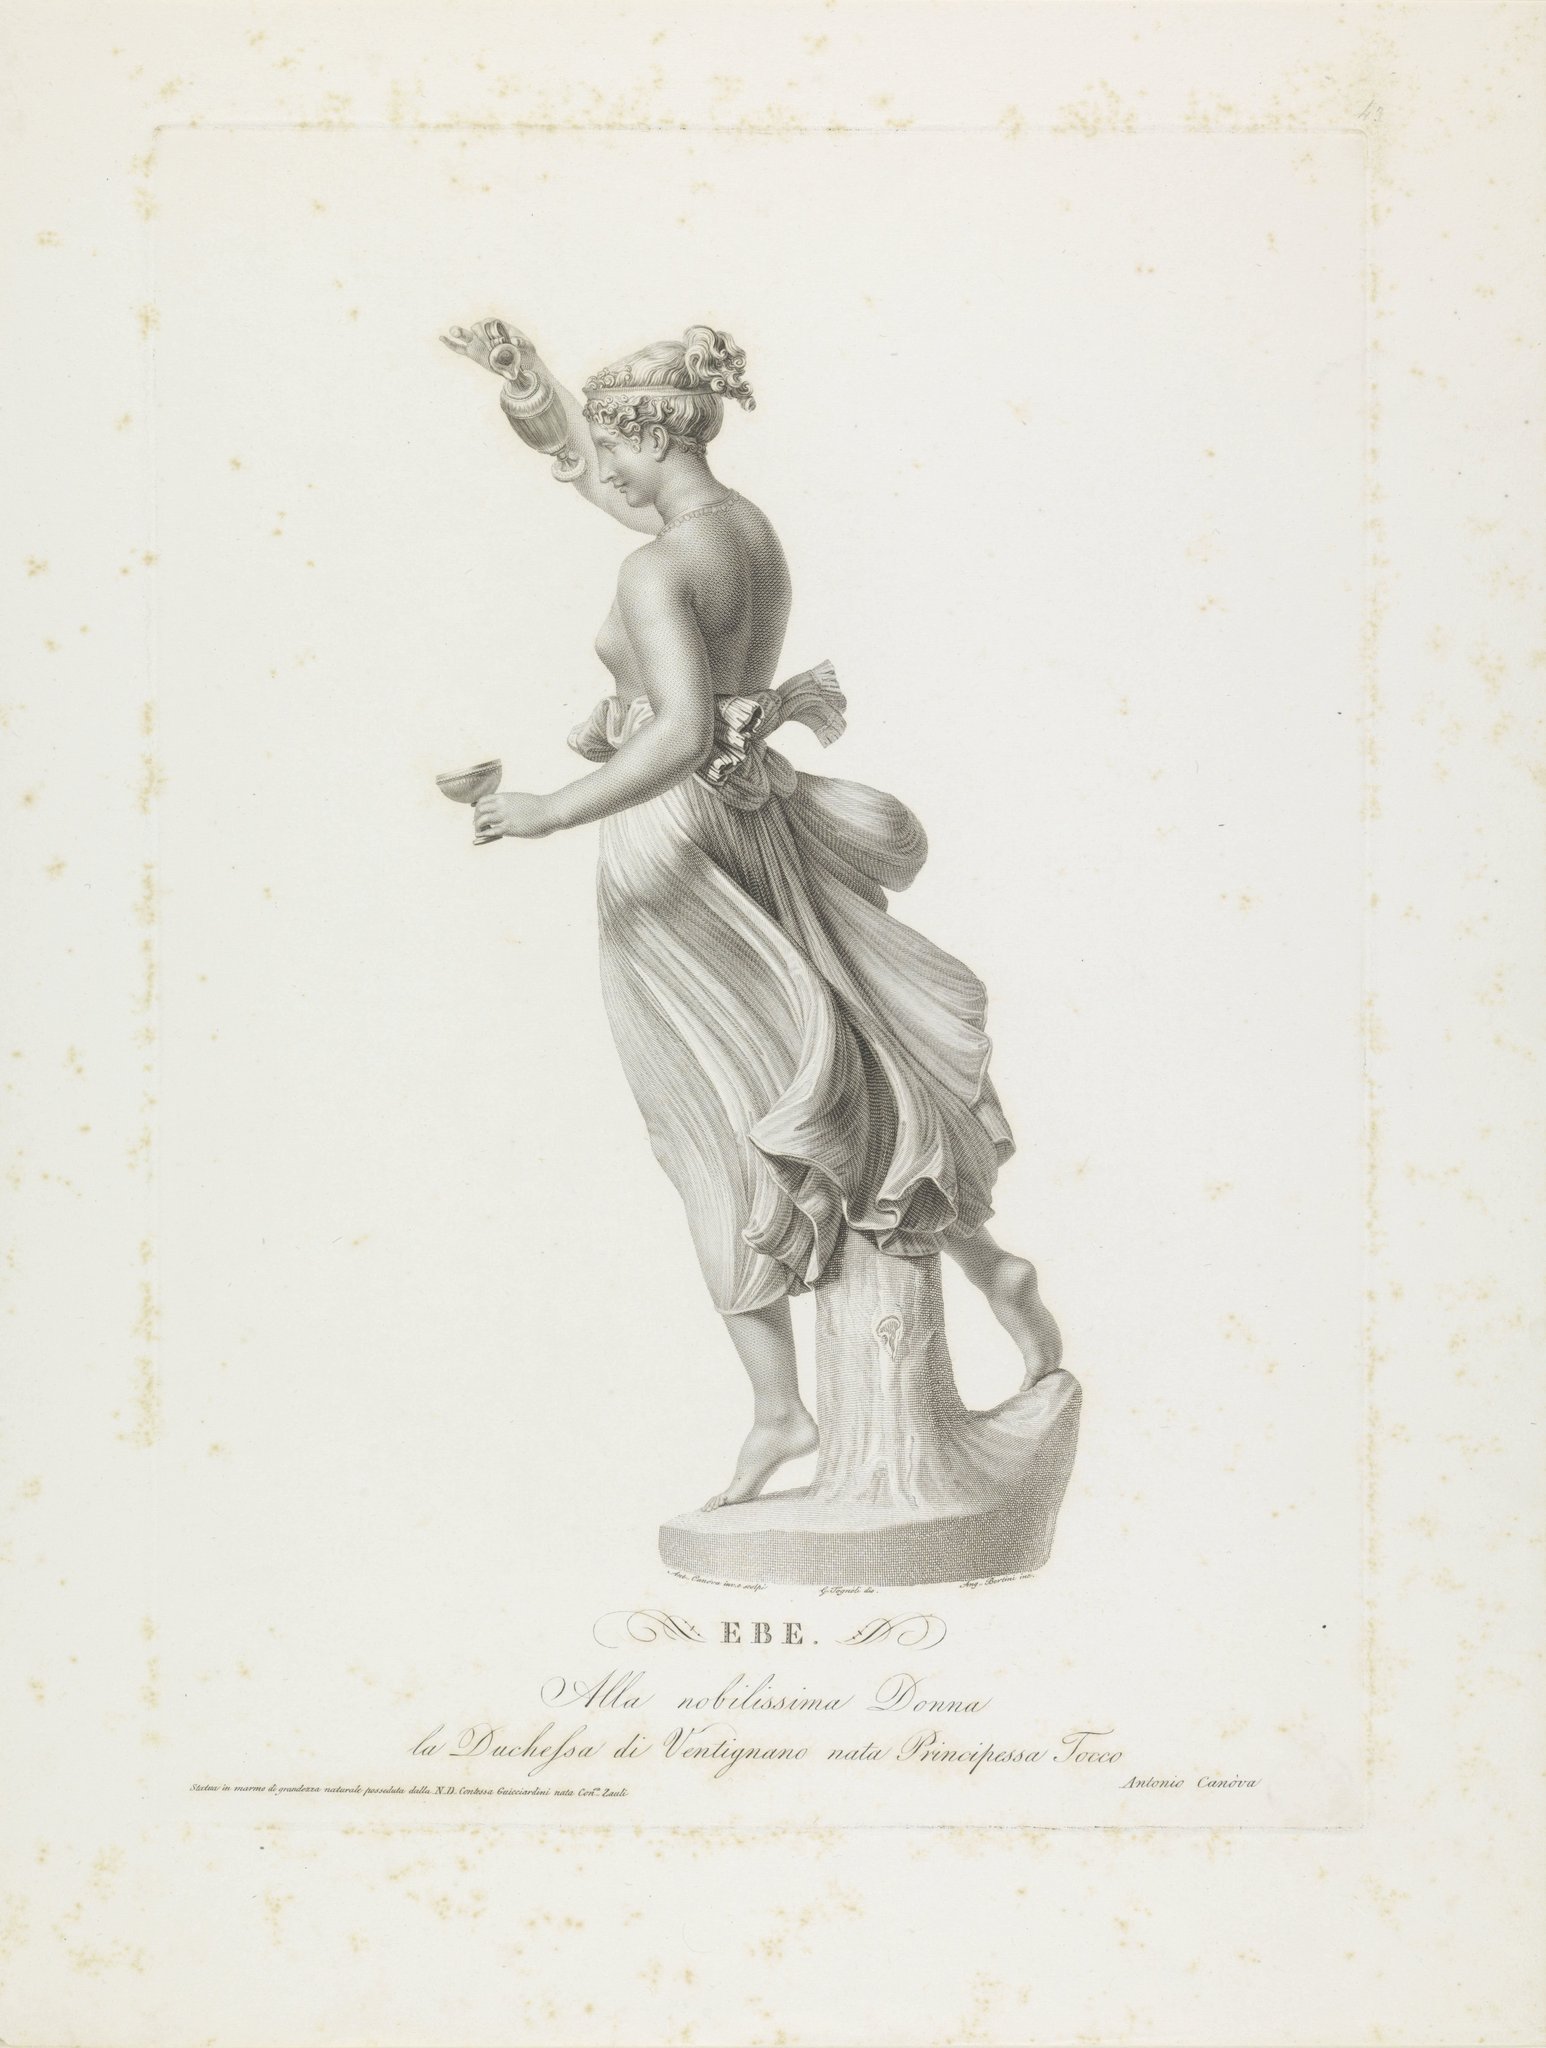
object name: print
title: Ebe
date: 1793-1838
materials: paper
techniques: engraving, etching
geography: italy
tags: (story of) hebe (juventas) - attributes, piece of sculpture, reproduction of a piece of sculpture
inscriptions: collector's mark: Lugt 12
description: Deze prent maakt deel uit van een reeks van onbekende omvang met voorstellingen van sculpturen van Antonio Canova door verschillende prentmakers naar tekeningen van Giovanni Tognolli. Het beeld van Canova bevindt zich in de Hermitage te St. Petersburg.